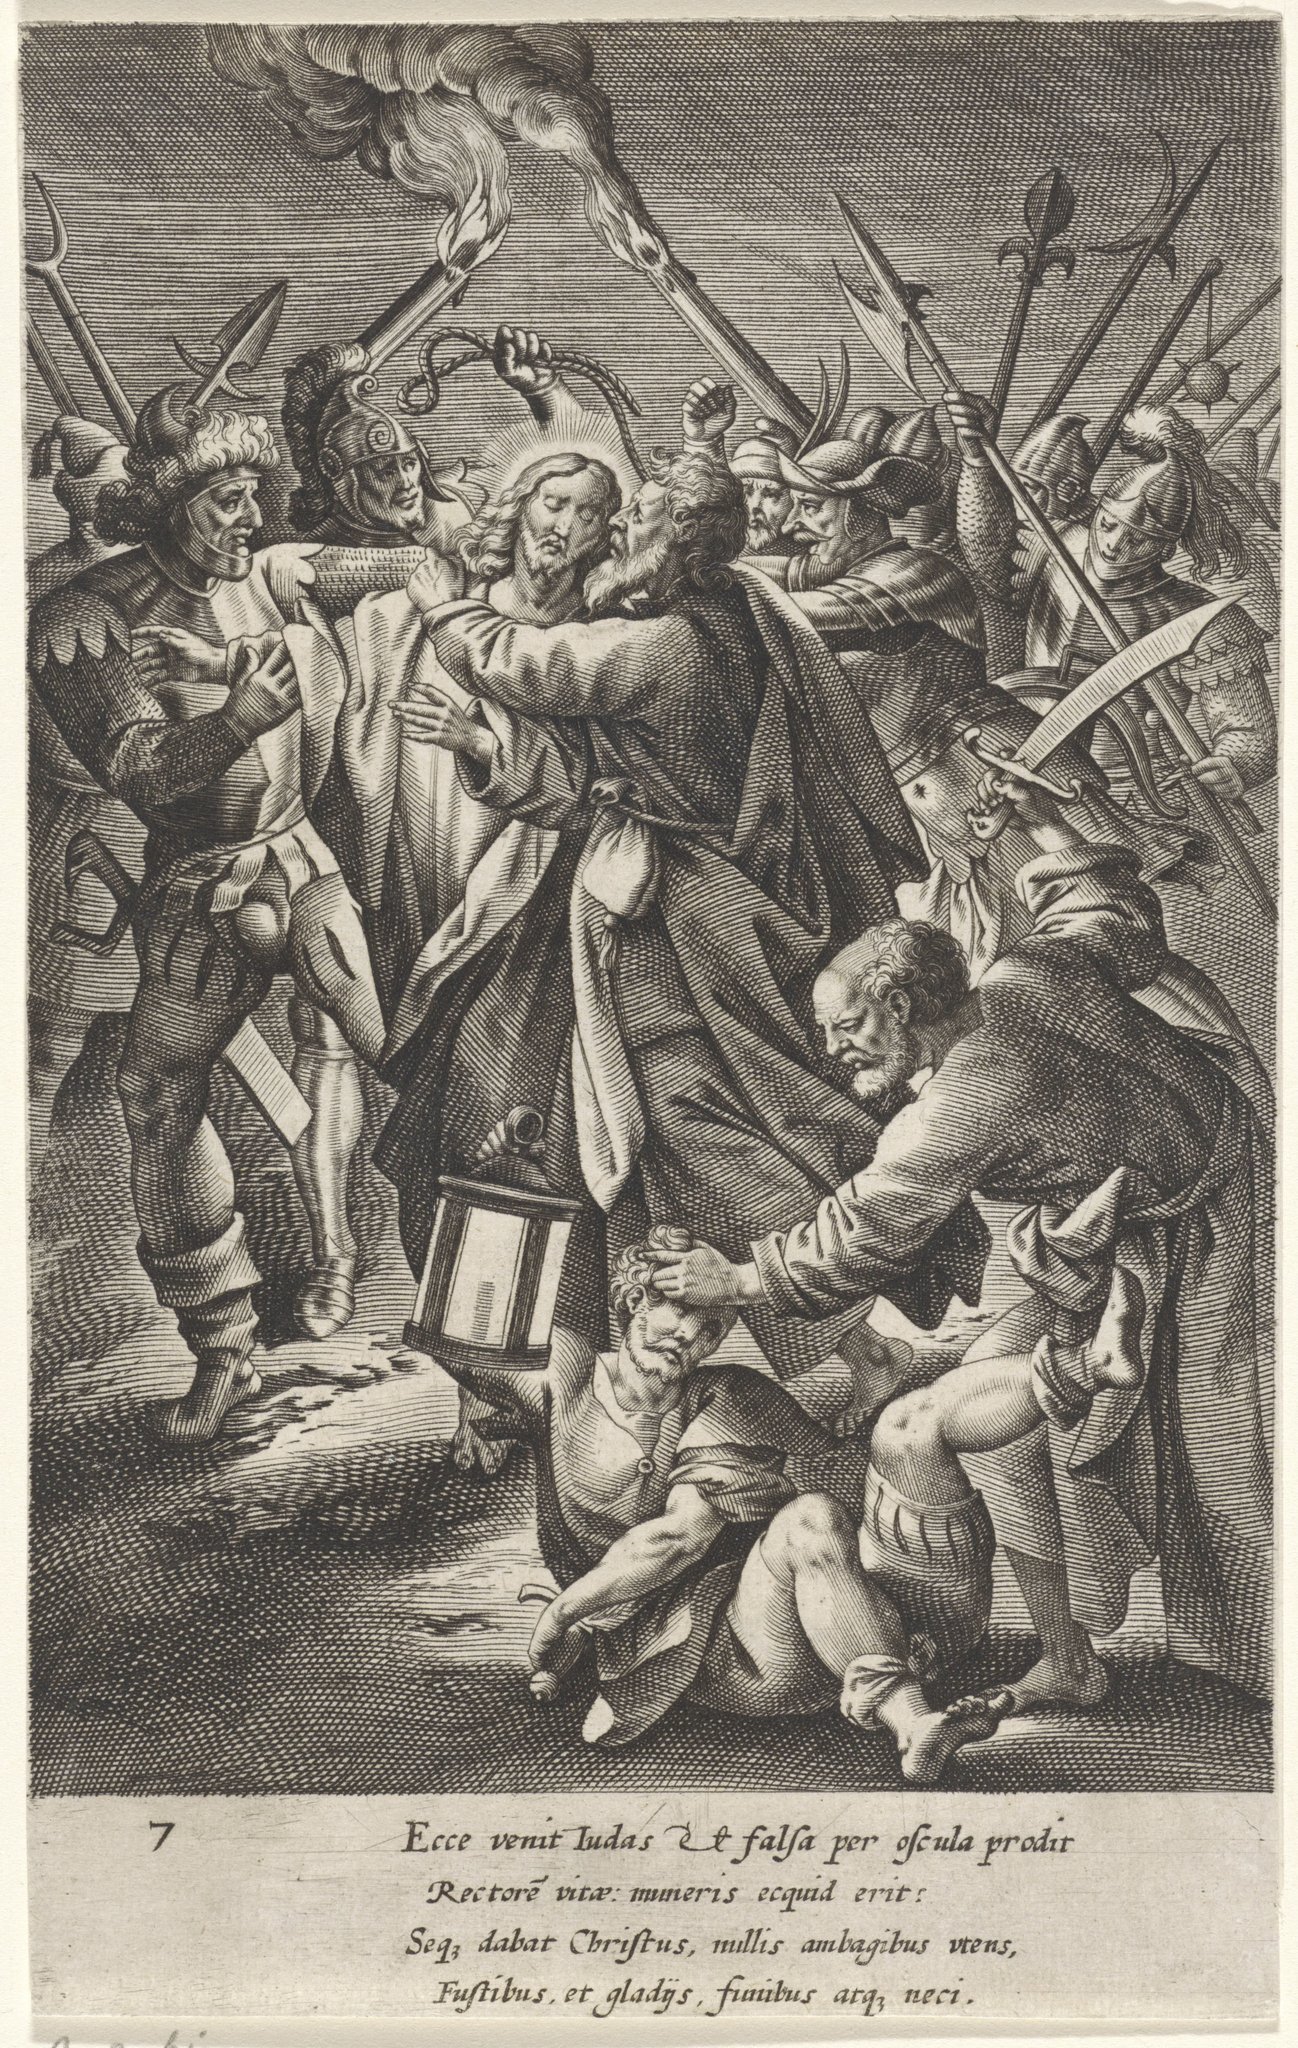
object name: print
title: Judaskus en arrestatie van Christus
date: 1583-1587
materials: paper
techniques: engraving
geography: antwerp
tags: peter draws his sword and cuts off malchus' ear, the kiss of judas: accompanied by soldiers with torches and lanterns, he kisses christ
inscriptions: collector's mark: Lugt 2228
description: Prent gebruikt in: Thesaurus sacrarum historiaru[m] veteris (et novi) testame[n]ti, elega[n]tissimis imaginibus expressu[m] excelle[n]tissimoru[m] in hac arte viroru[m] opera : nu[n]c primu[m] in luce[m] editus. Antwerpen: Gerard de Jode, 1585.